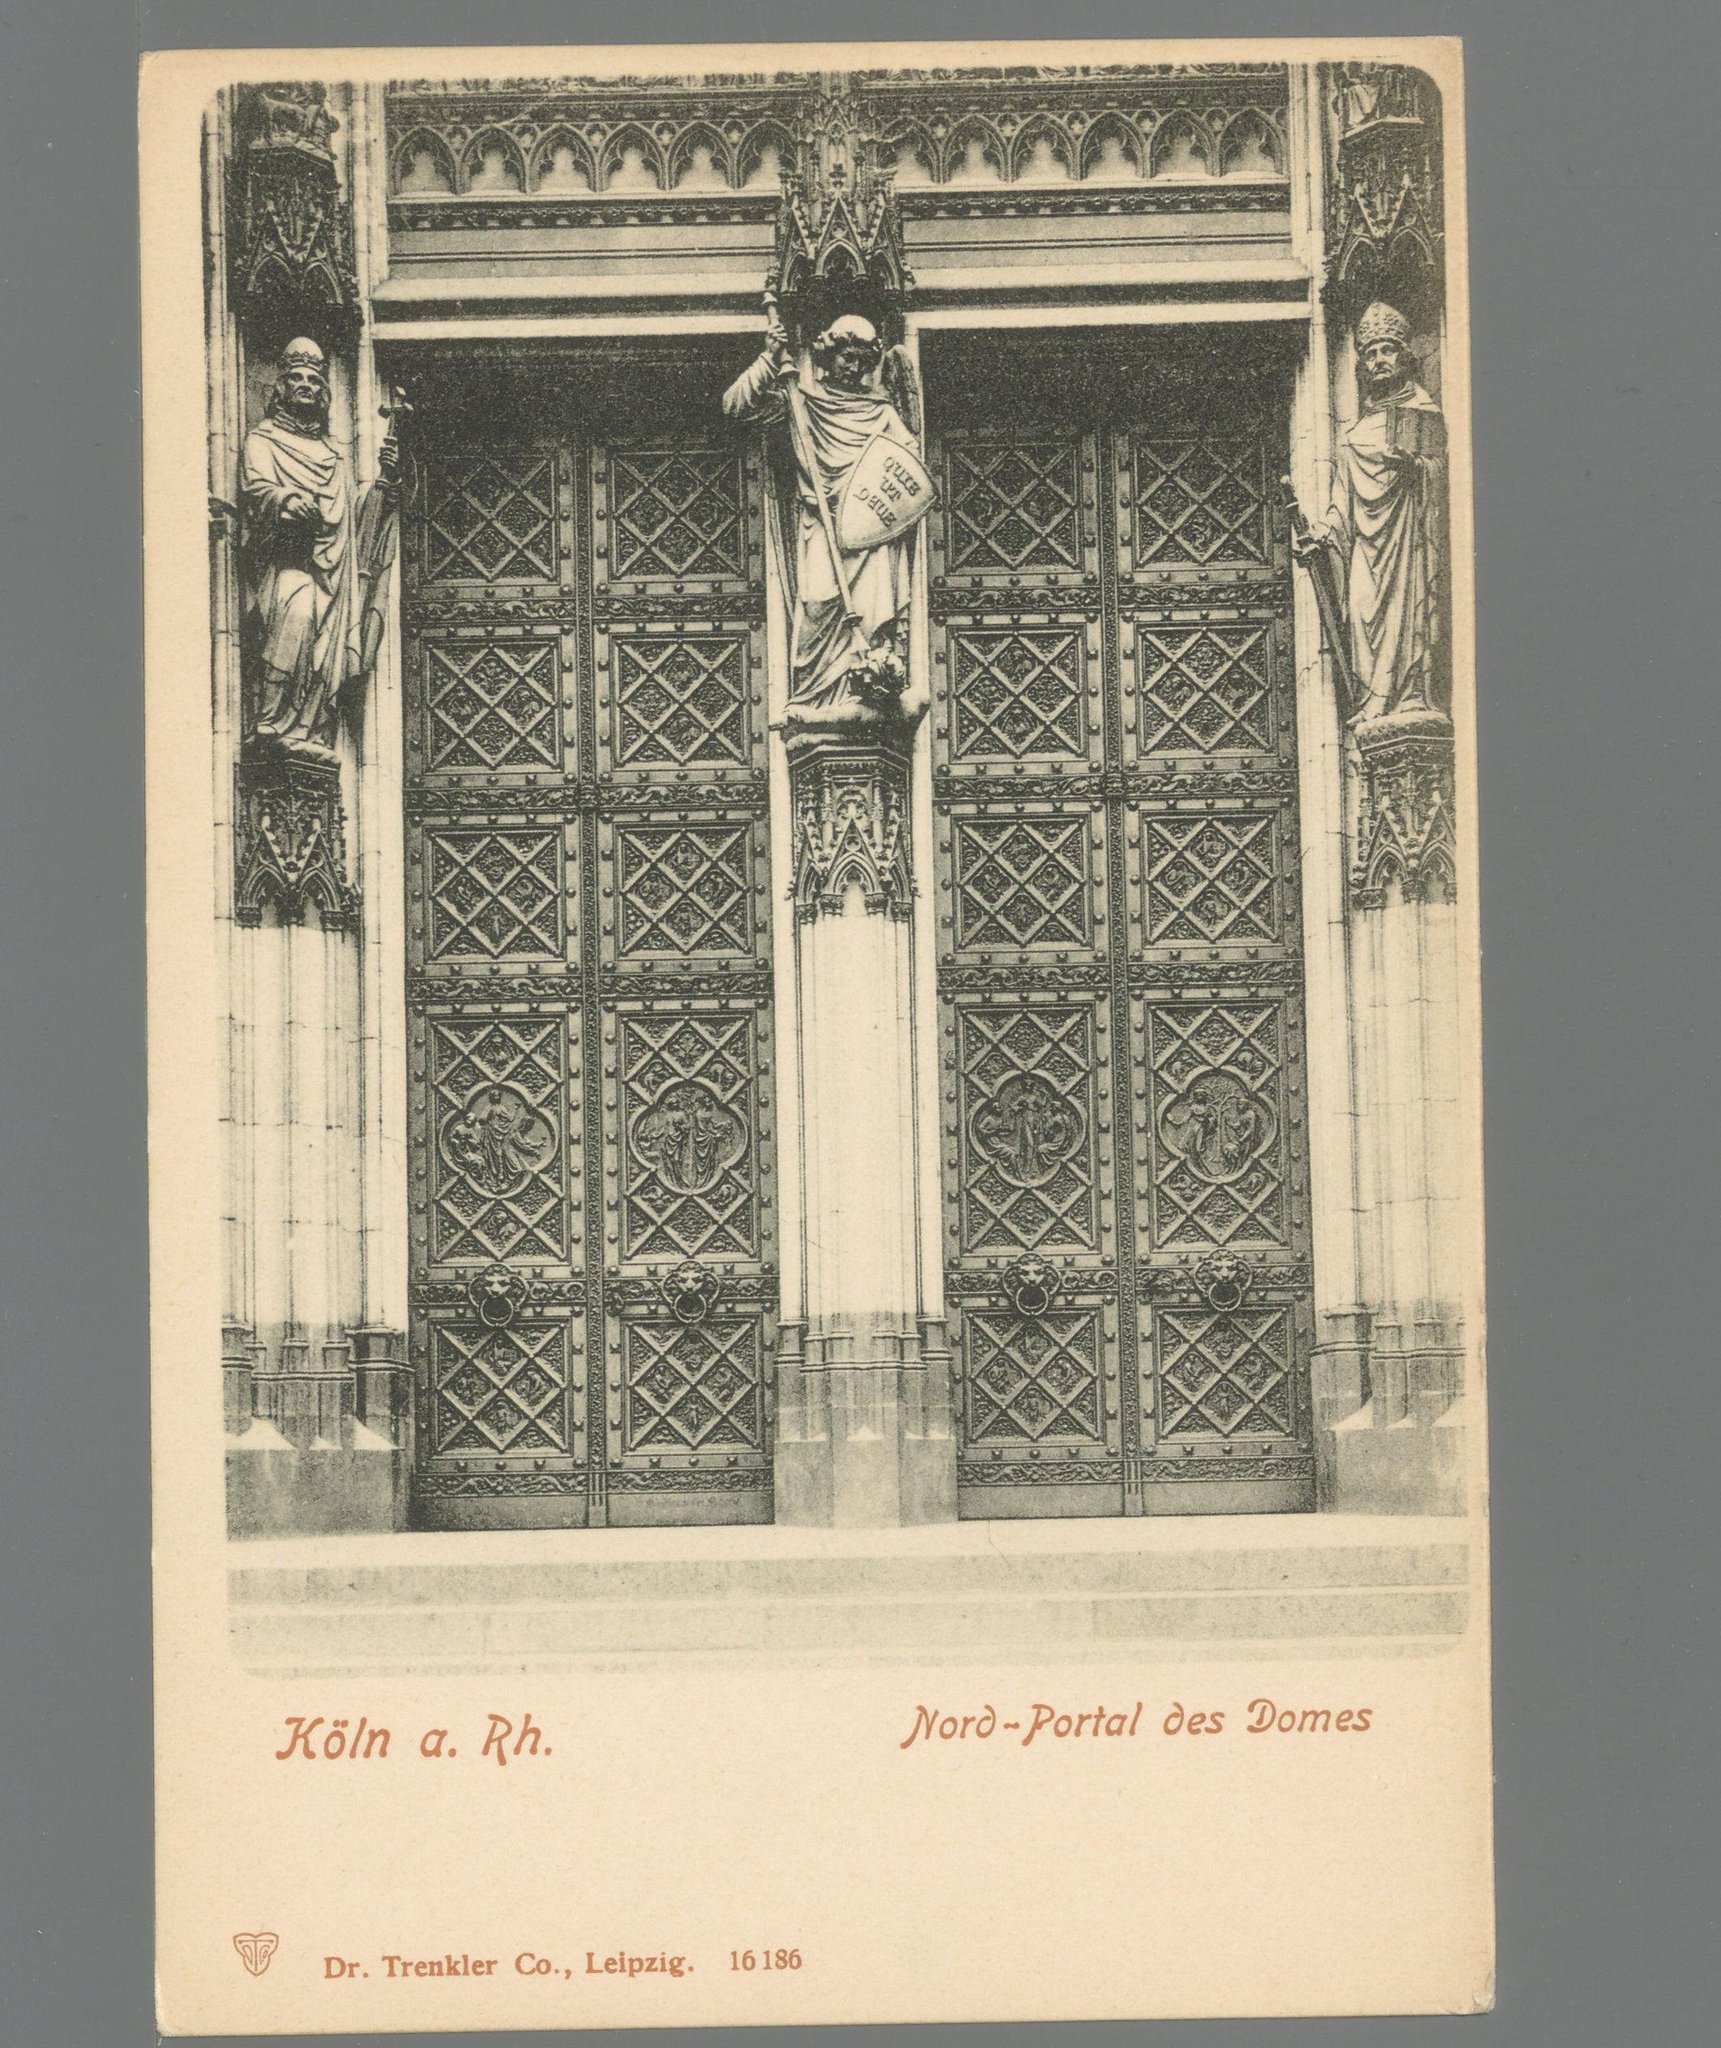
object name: photomechanical print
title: Köln a. Rh. Nord-Portal der Domes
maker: Anonymous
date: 1894-1905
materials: cardboard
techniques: photograph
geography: leipzig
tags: church (exterior), gate, entrance